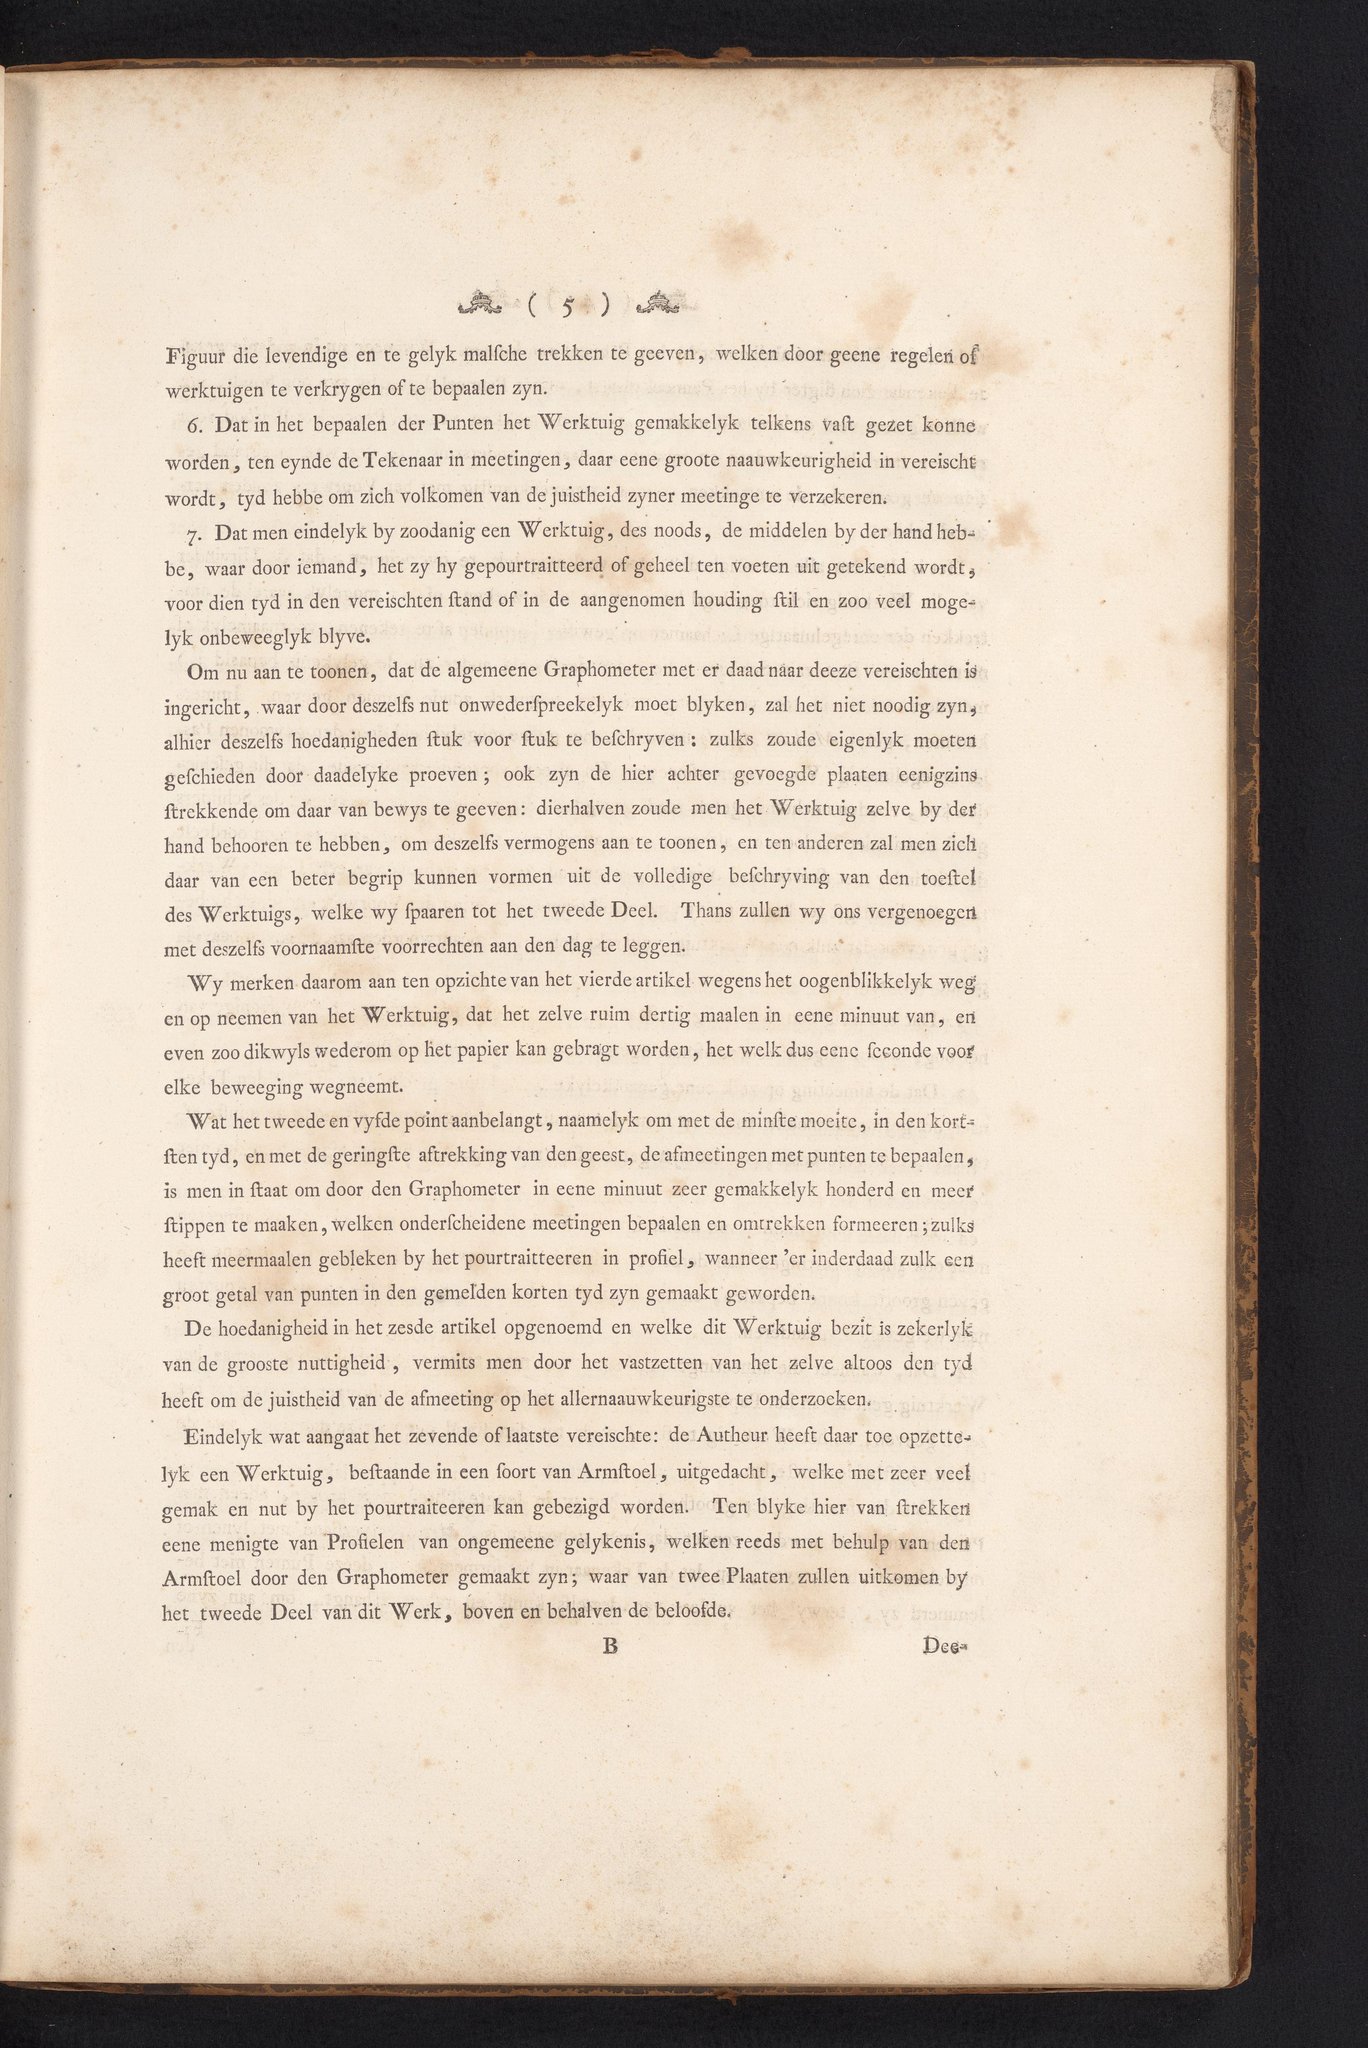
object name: text sheet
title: Beschrijving van het nut van de grafometer, pagina 5 van 10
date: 1777-1778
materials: paper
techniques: letterpress printing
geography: the hague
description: Het tekstblad maakt deel uit van het boek: A.G. Eckhardt, Beschryving van een algemeenen graphometer, 1778.